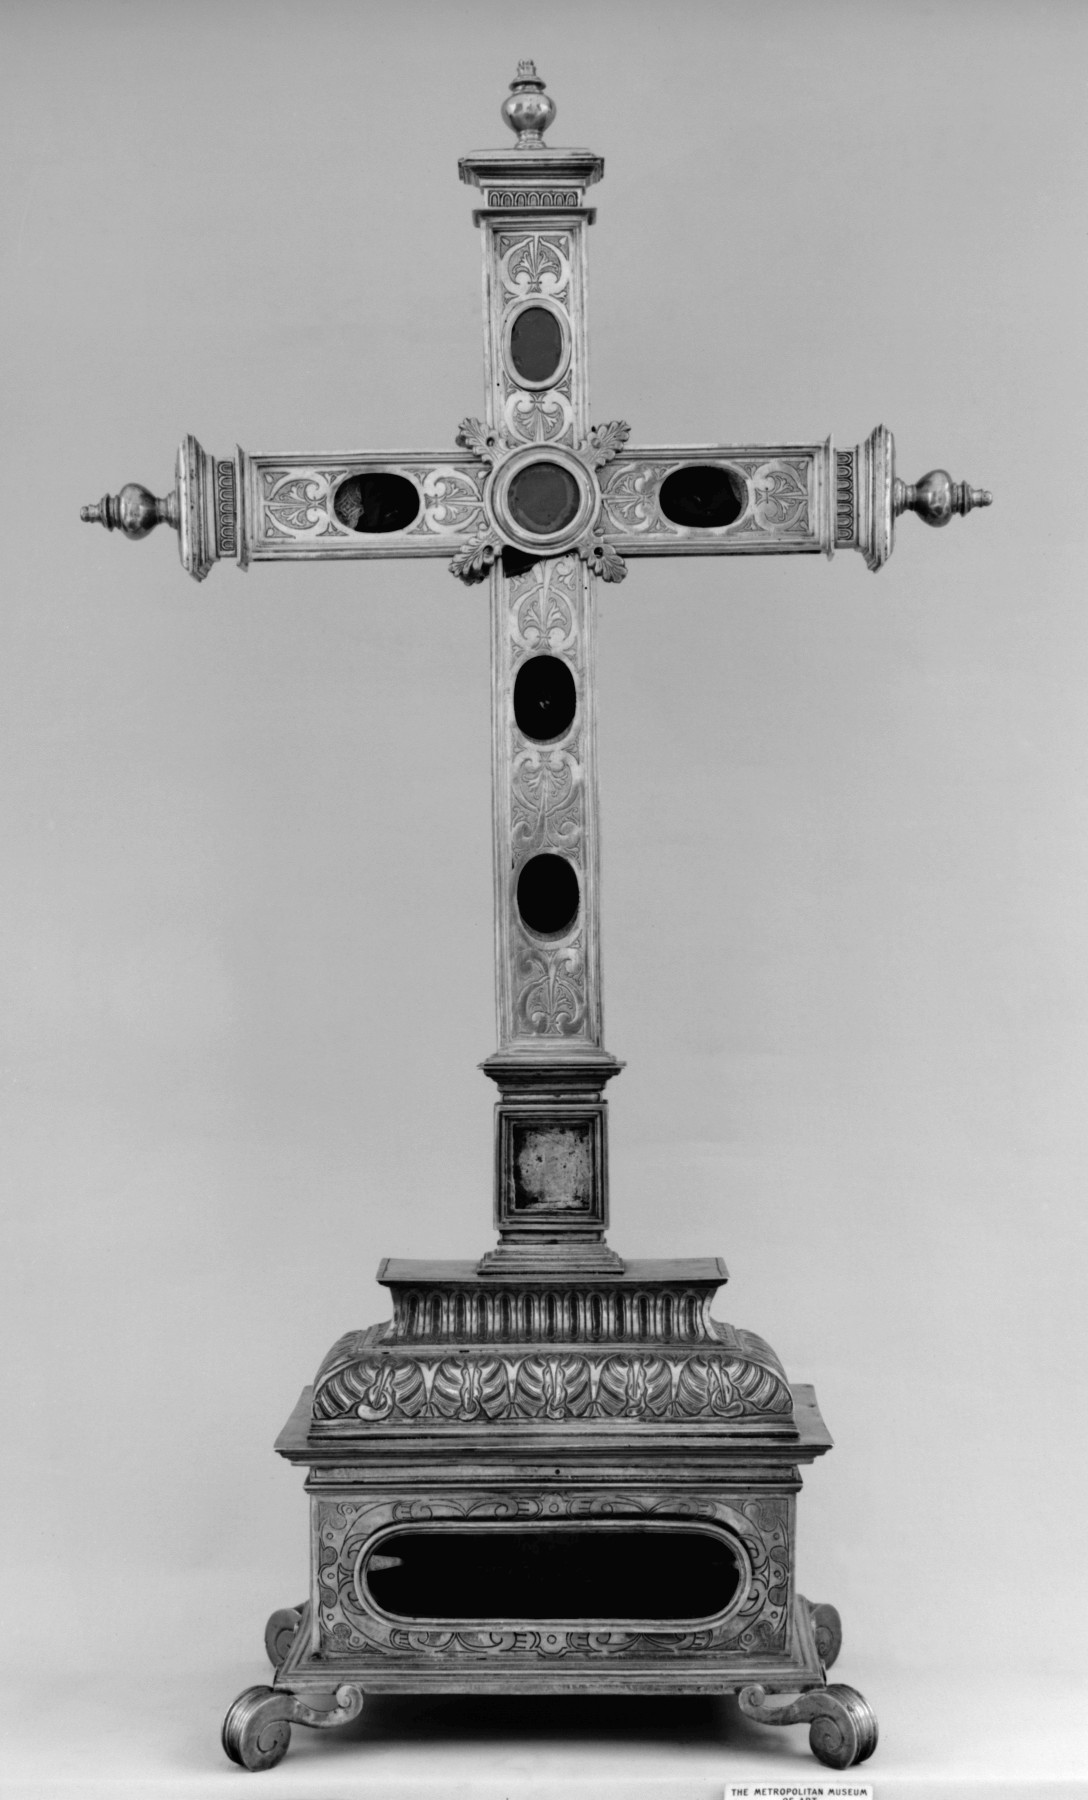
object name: reliquary cross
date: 1601-1633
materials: silver gilt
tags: cross,reliquaries